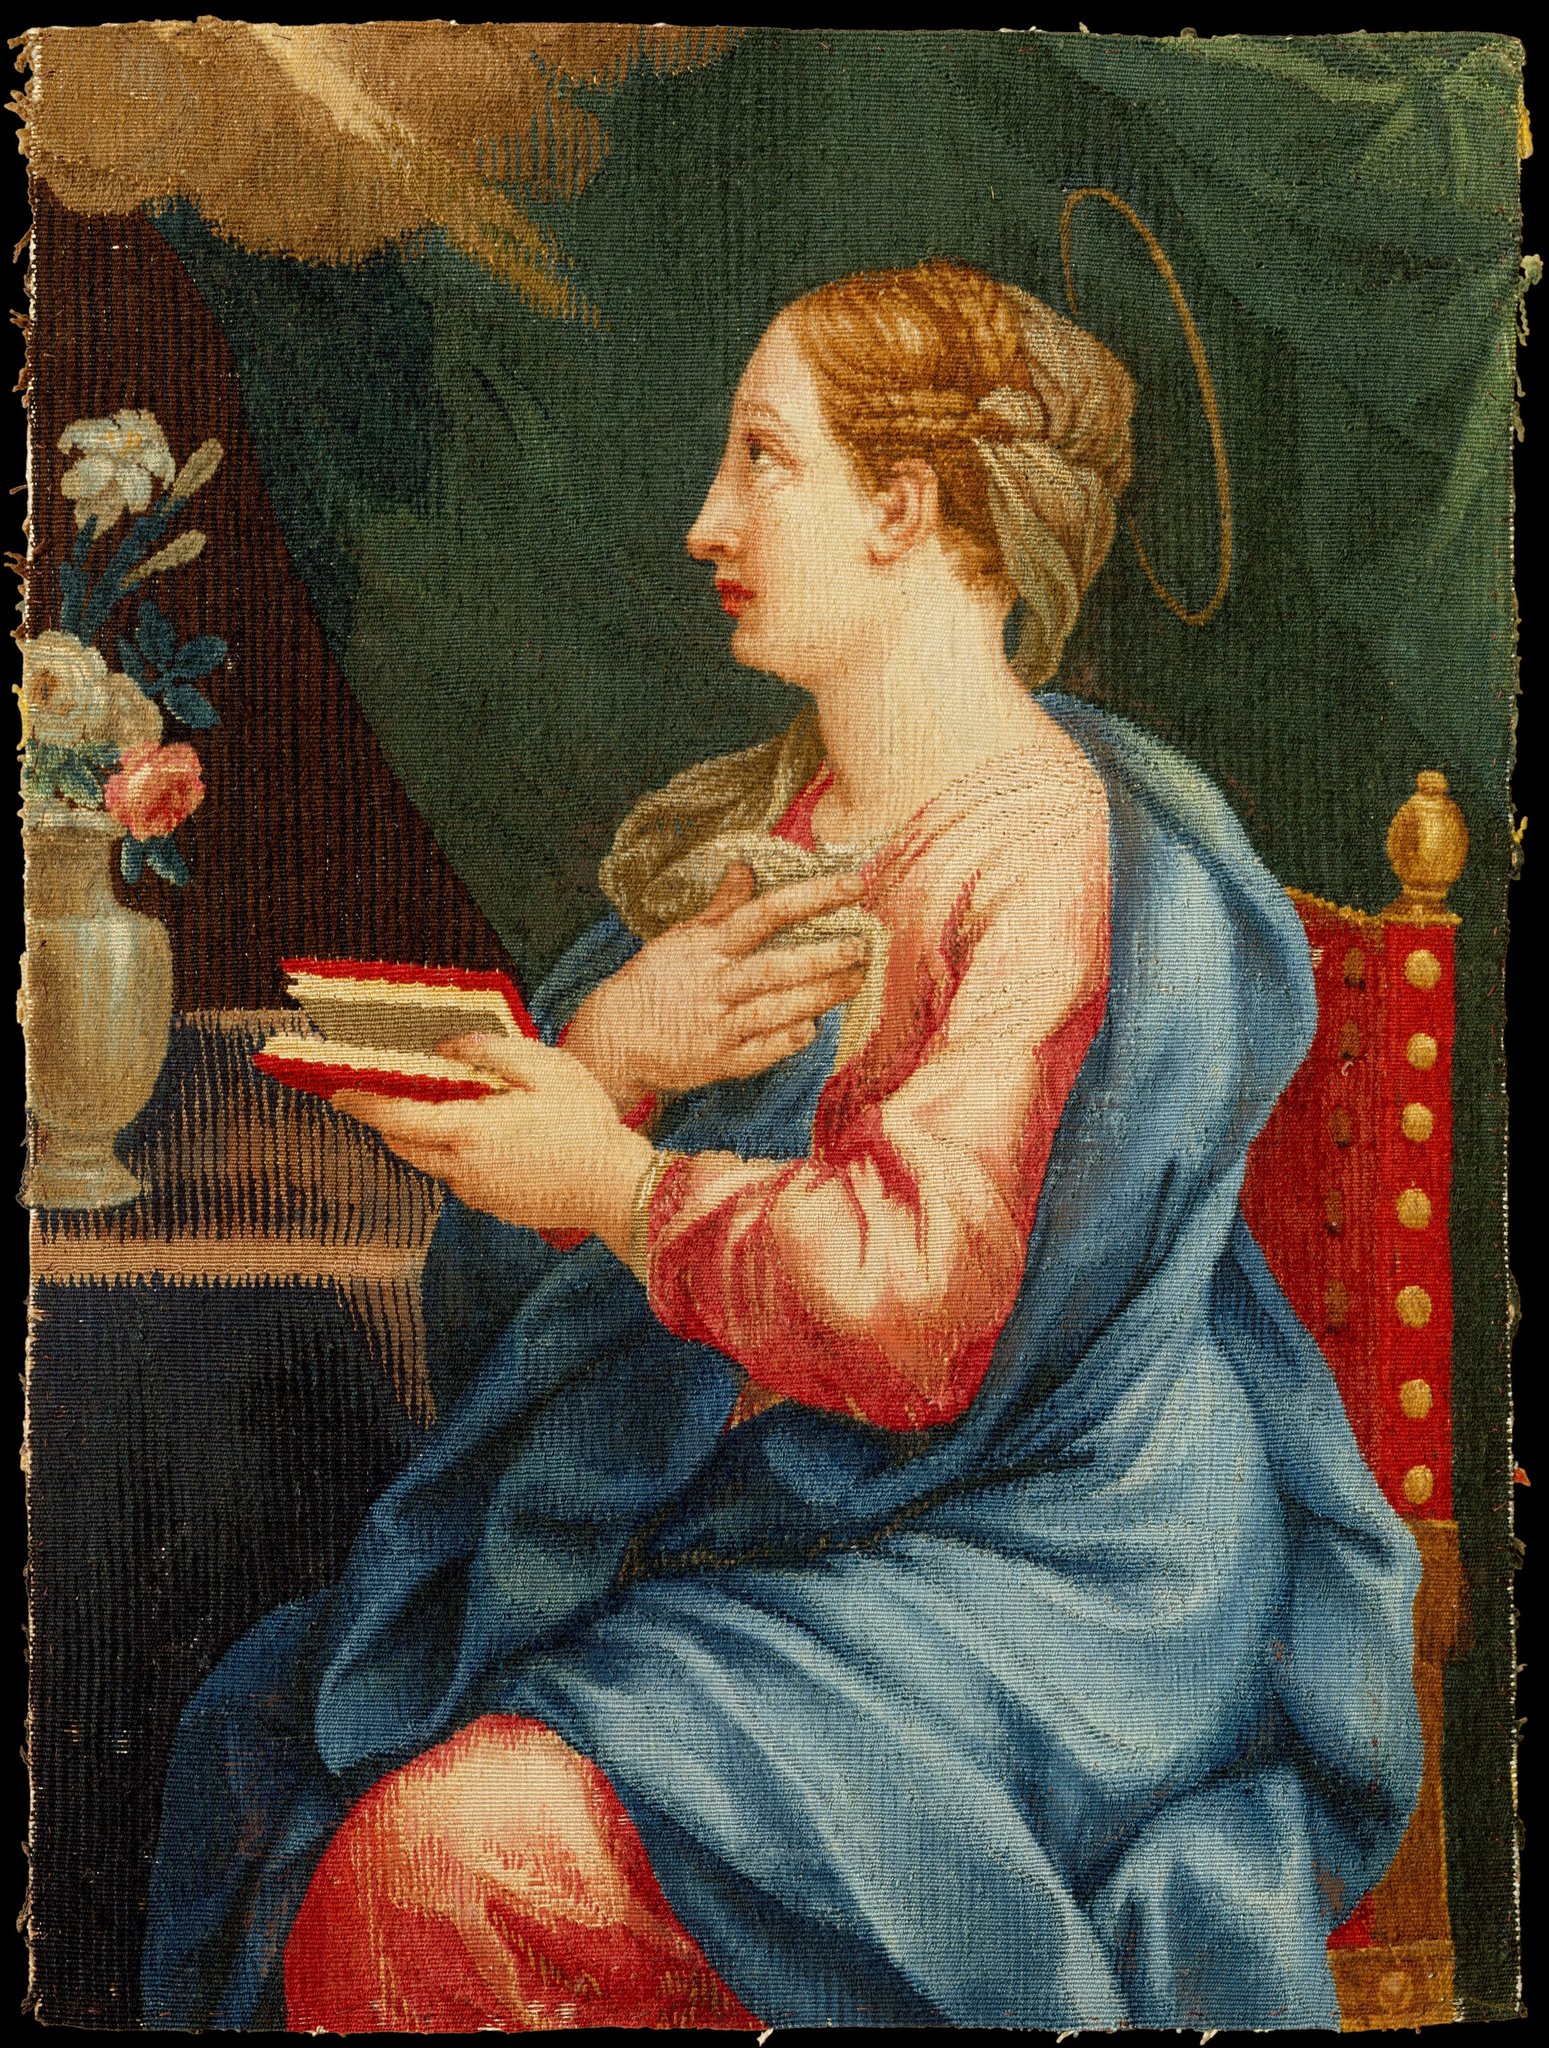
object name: tapestry fragment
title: The Virgin Annunciate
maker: pietro ferloni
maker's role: artist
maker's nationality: italian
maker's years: 1717-1770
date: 1734-1766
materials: silk, wool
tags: flowers,virgin mary,annunciation